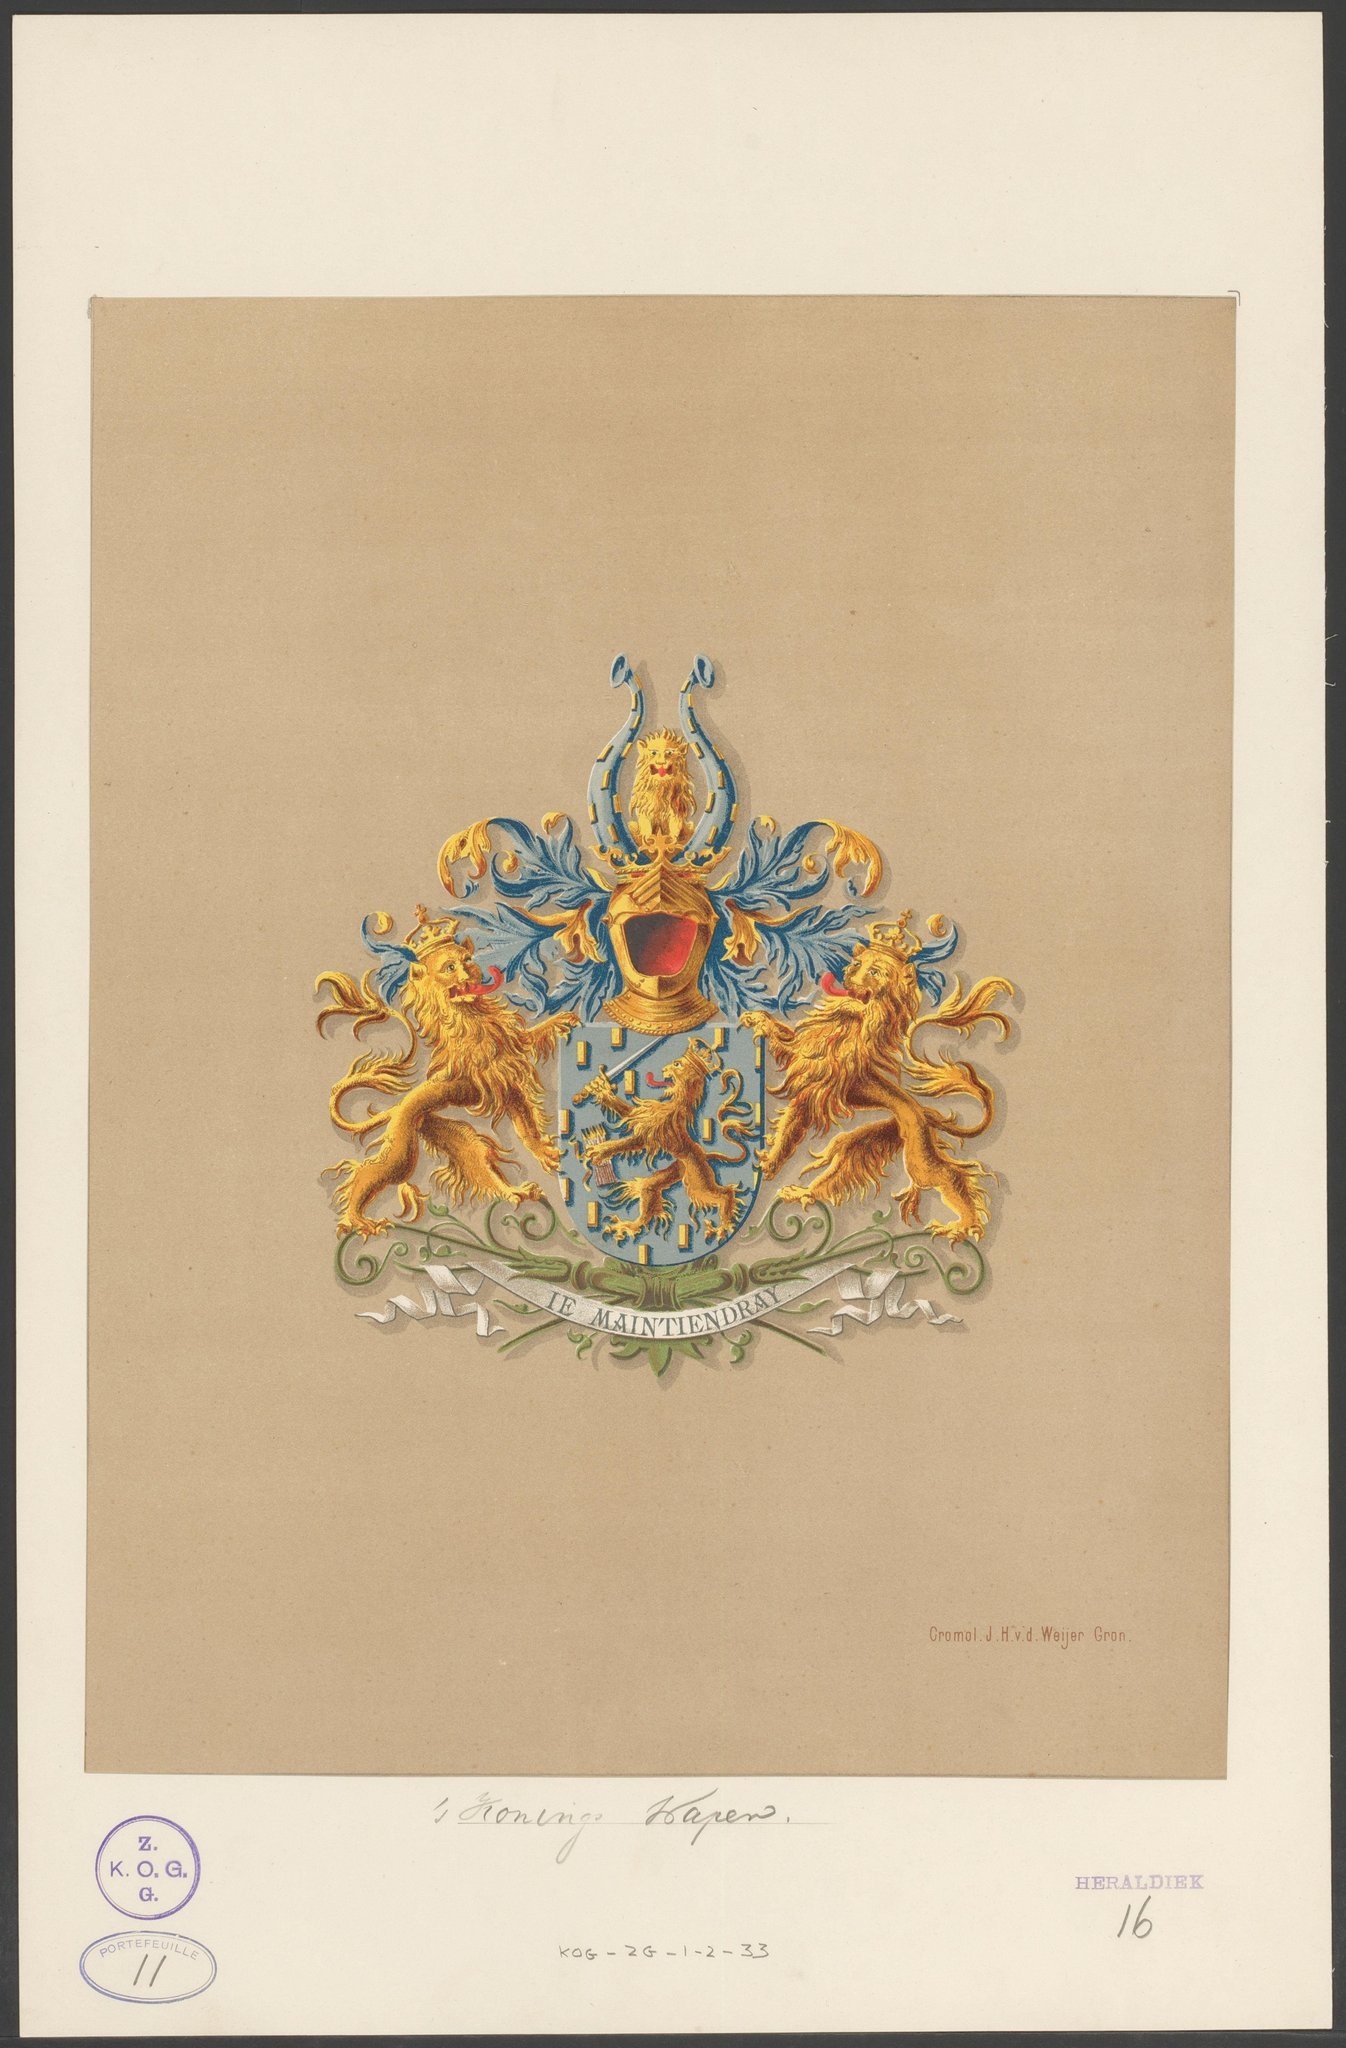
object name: print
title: 's Konings Wapen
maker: johannes hermanus van de weijer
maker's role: print maker, printer, publisher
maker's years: 1817-1889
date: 1840-1876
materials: paper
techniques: chromolithography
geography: groningen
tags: armorial bearing, heraldry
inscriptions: collector's mark: Lugt 1641, collector's mark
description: Wapen van de koning van het Koninkrijk der Nederlanden. Wapendier en schilderhouders nog met rangkronen. Met motto, gouden helm met zittende leeuw tussen trompen als helmteken. Onderwerpsrubrieken binnen de Atlas Zeden en Gewoonten: Regeering, Wapens (Heraldiek), Wapens van Regeerende Huizen.